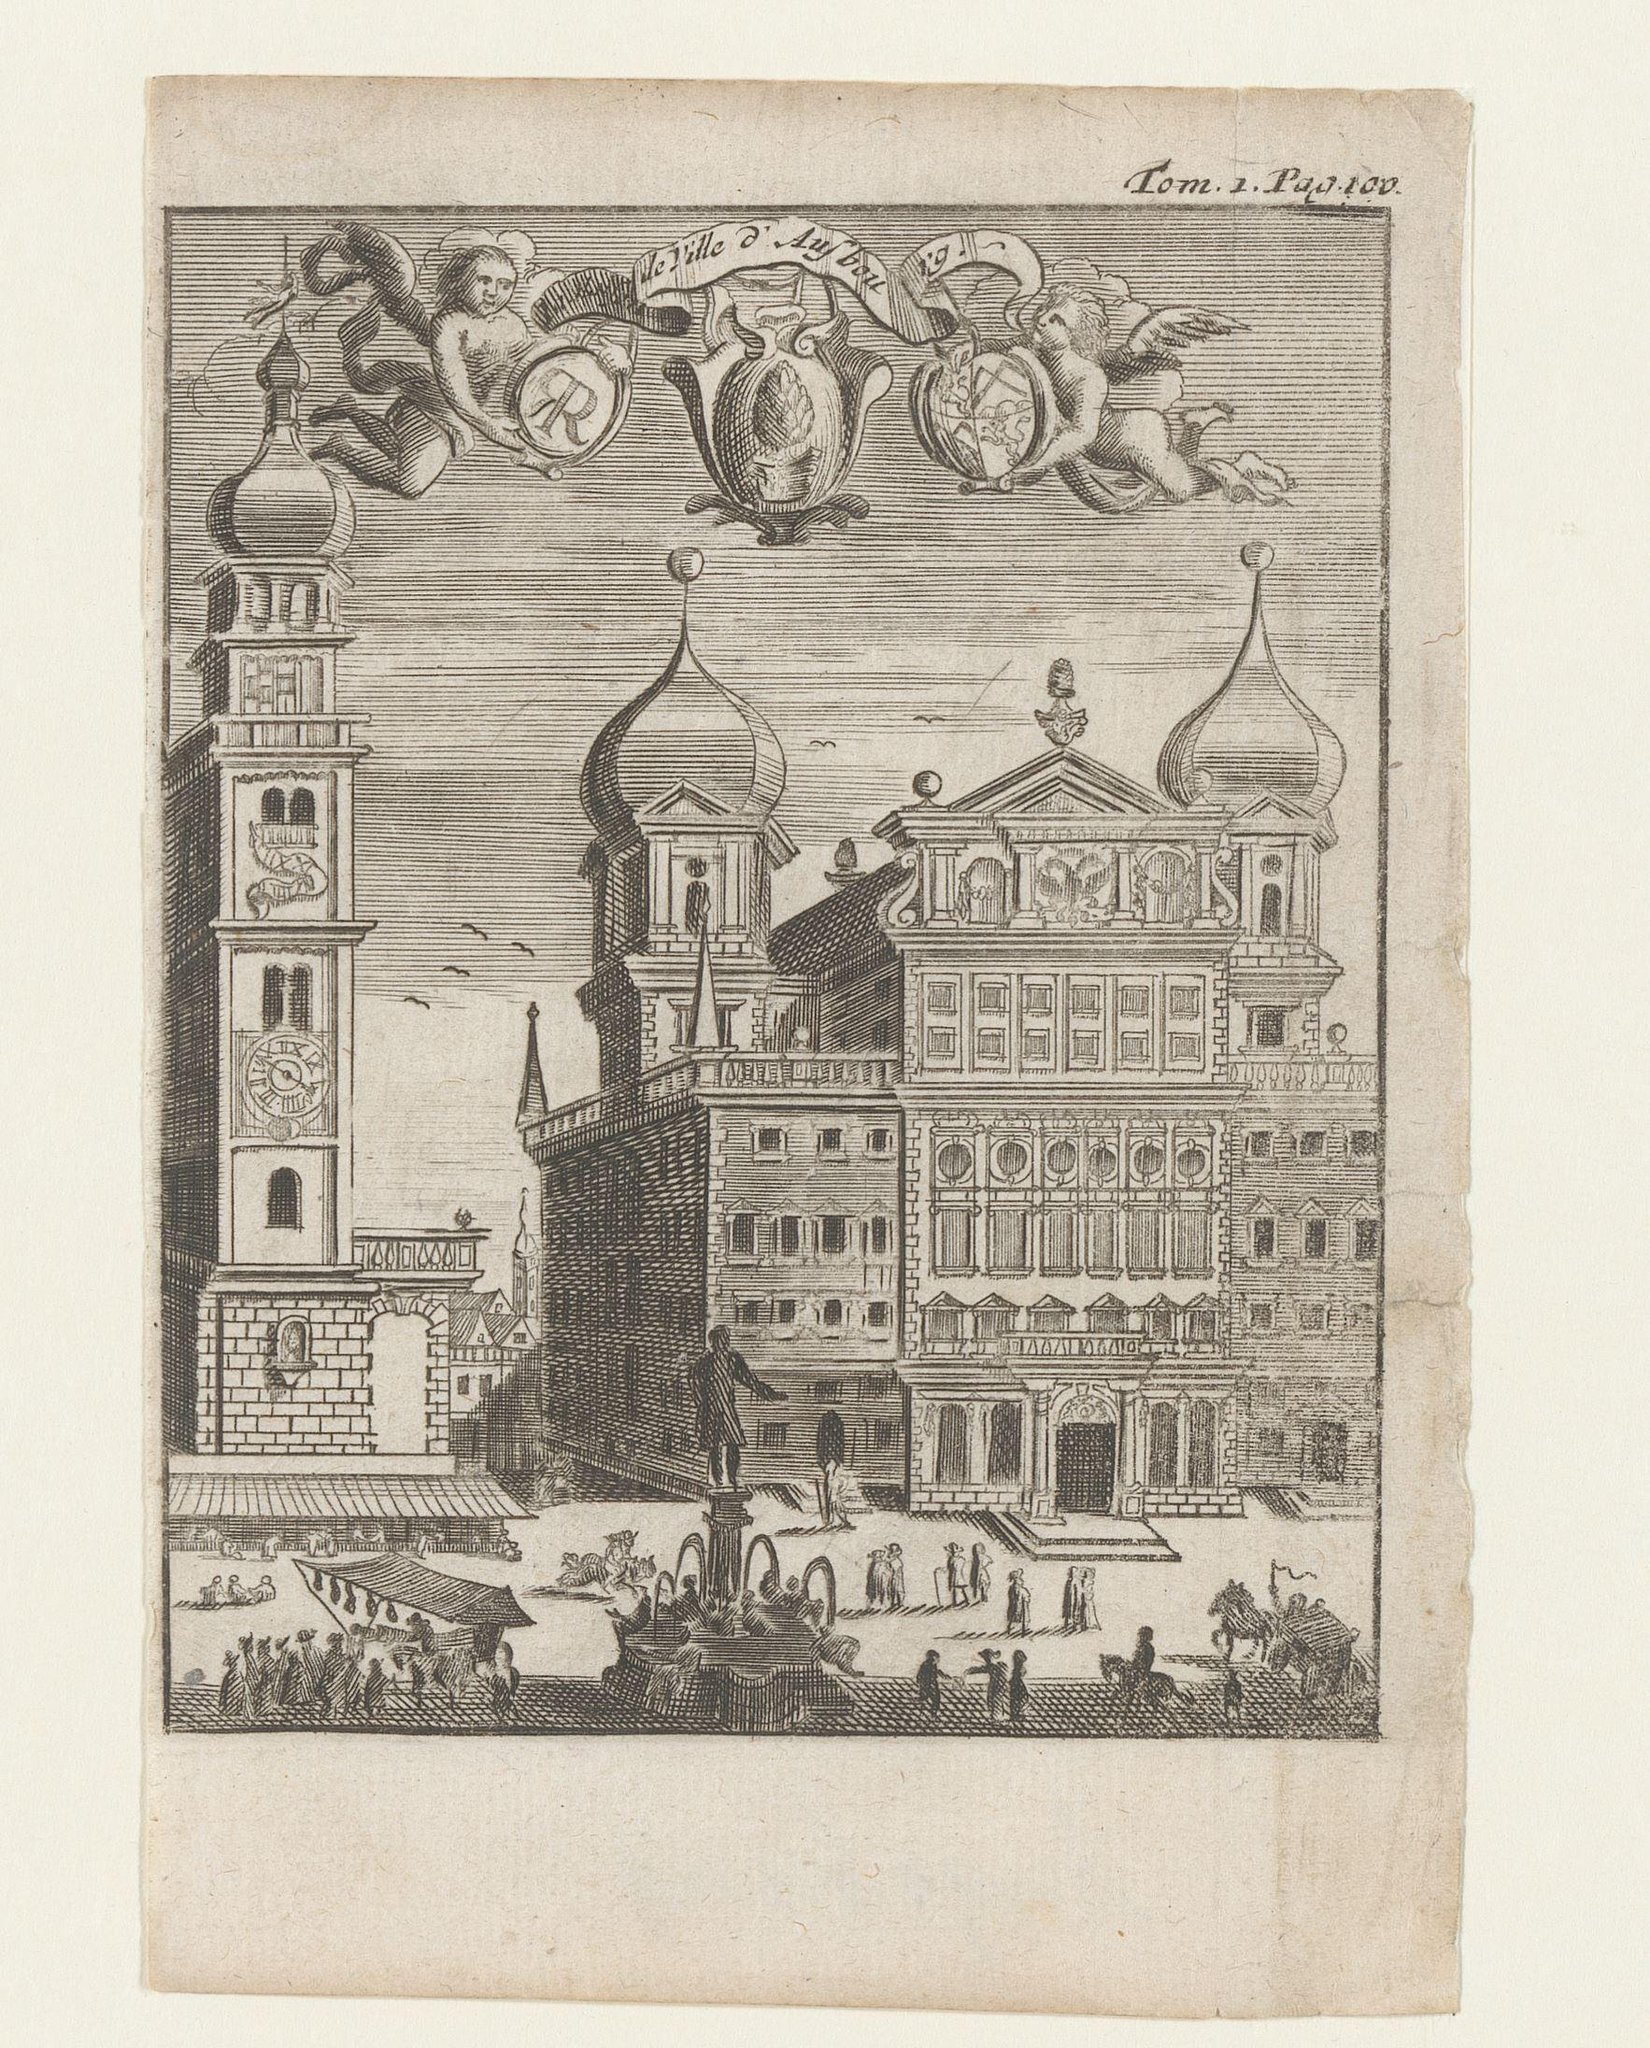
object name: print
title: Gezicht op het stadhuis en de Perlachturm-toren, te Augsburg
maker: Anonymous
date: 1620-1719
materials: paper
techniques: engraving, etching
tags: square, place, circus, etc., tower, clock tower ~ monumental adornment, townhall, ornamental fountain, augsburg